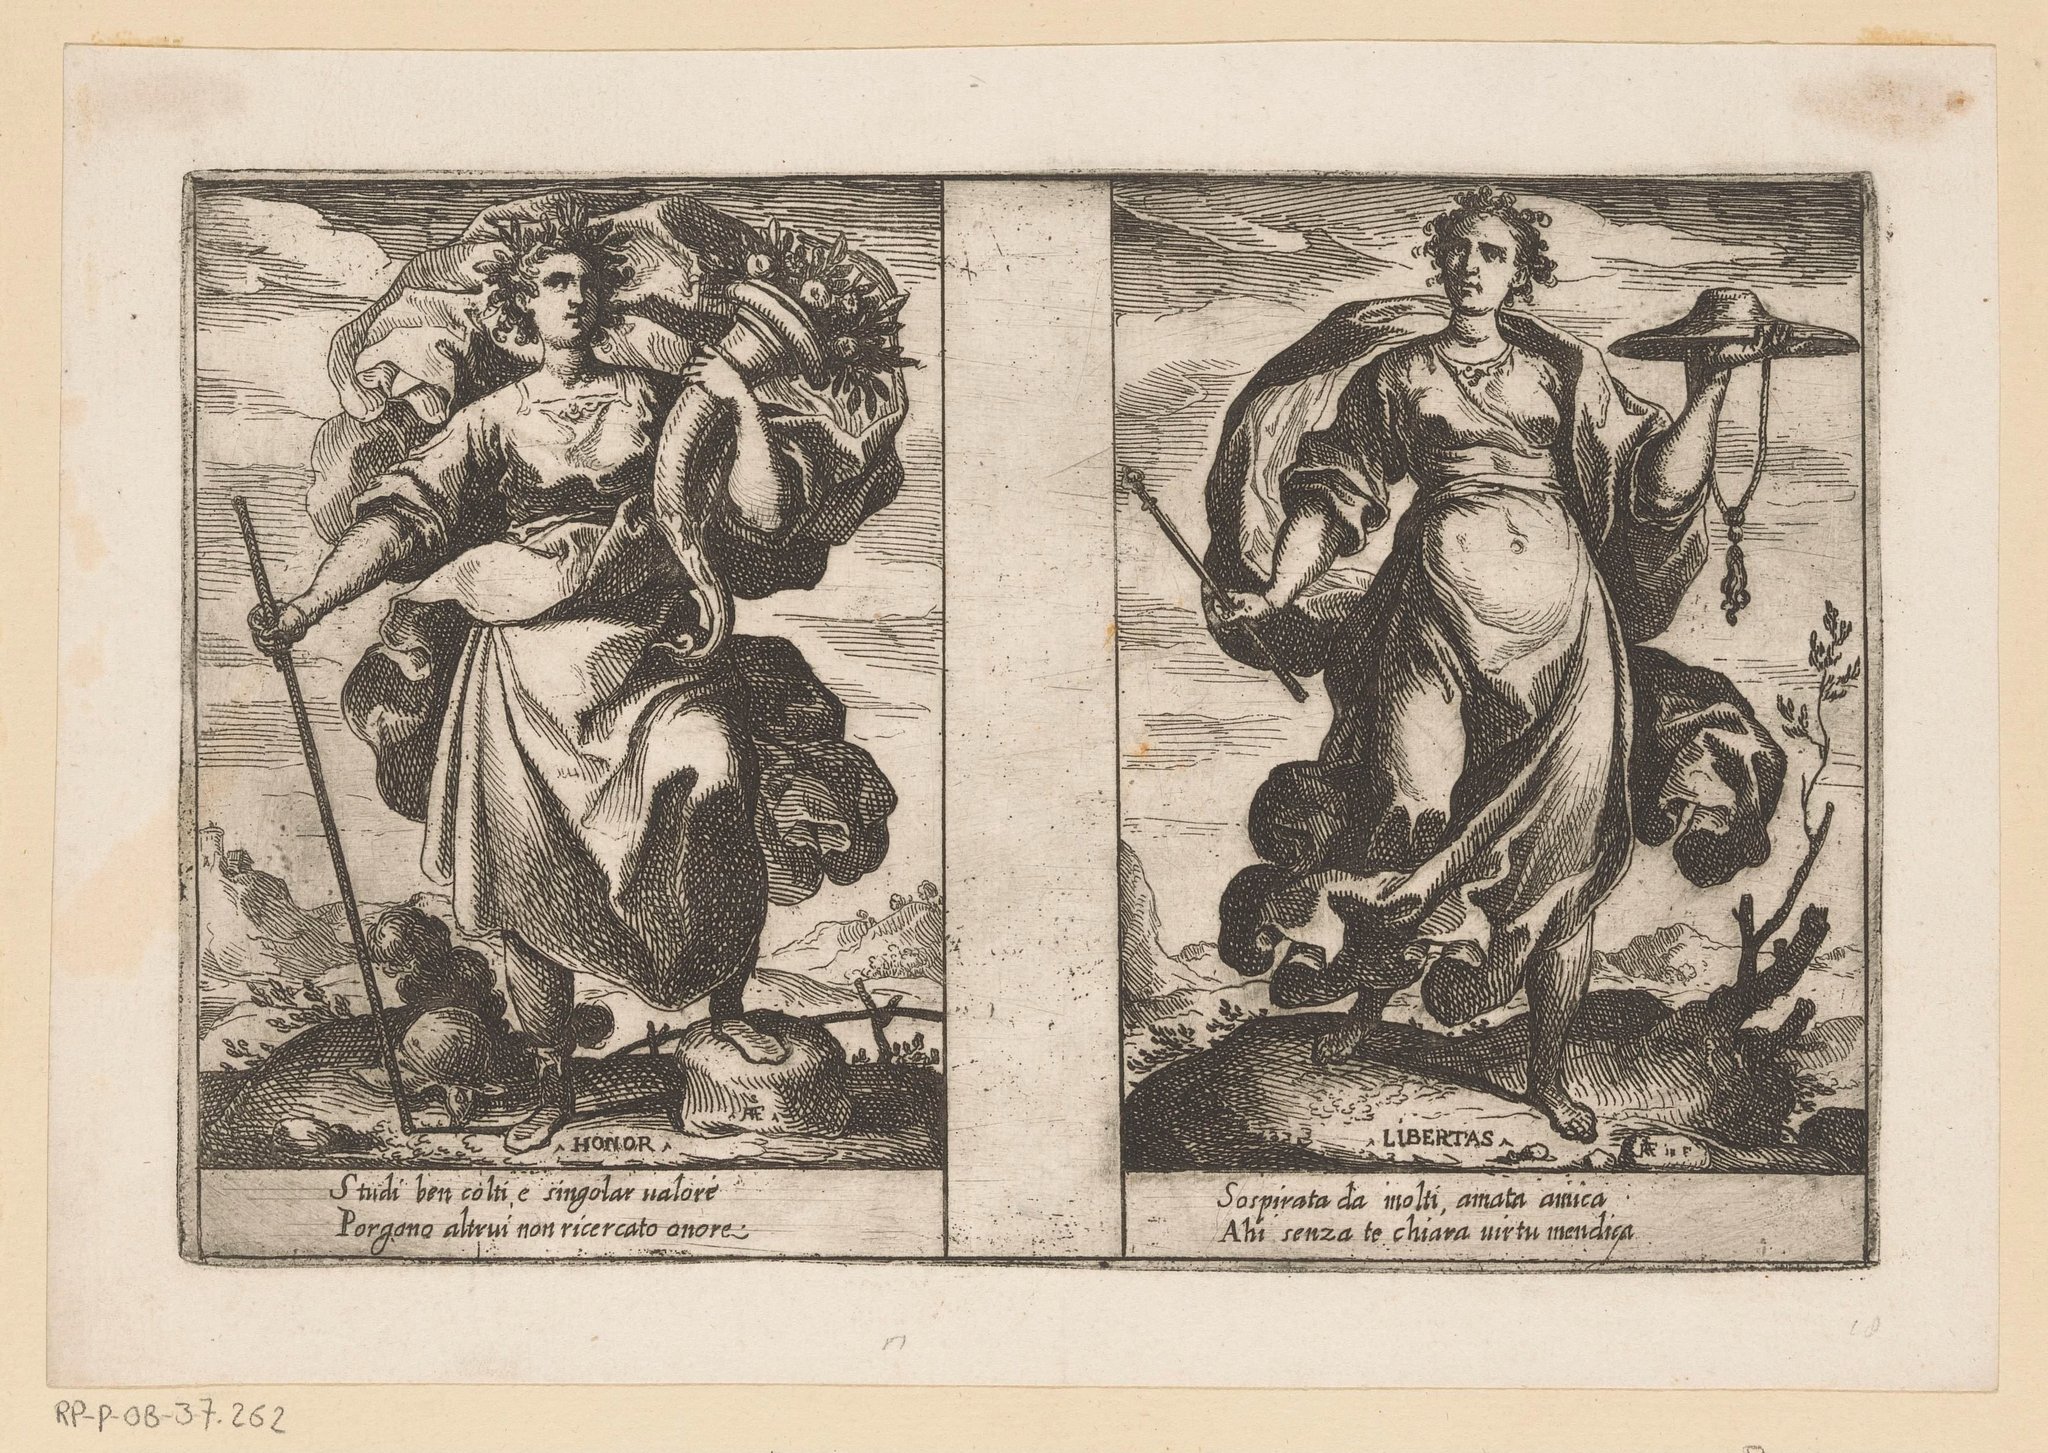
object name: print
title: Attributen van de ziel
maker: raffaello schiaminossi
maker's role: painter, print maker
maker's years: 1572-1622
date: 1605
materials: paper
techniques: etching, intaglio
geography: italy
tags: 'cornucopia', horn of plenty, freedom, liberty; 'libertà' (ripa), honour, glory; 'ampiezza della gloria', 'gloria', 'gloria de prencipi', 'gloria & honore', 'honore', 'sublimatà della gloria' (ripa)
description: Twee voorstellingen van personificaties. Links: eer (Honor) als vrouw met de hoorn des overvloeds (cornucopia). Rechts: vrijheid (Libertas) als vrouw met een hoed en een scepter. Beide voorstellingen met twee Italiaanse versregels in de ondermarge.